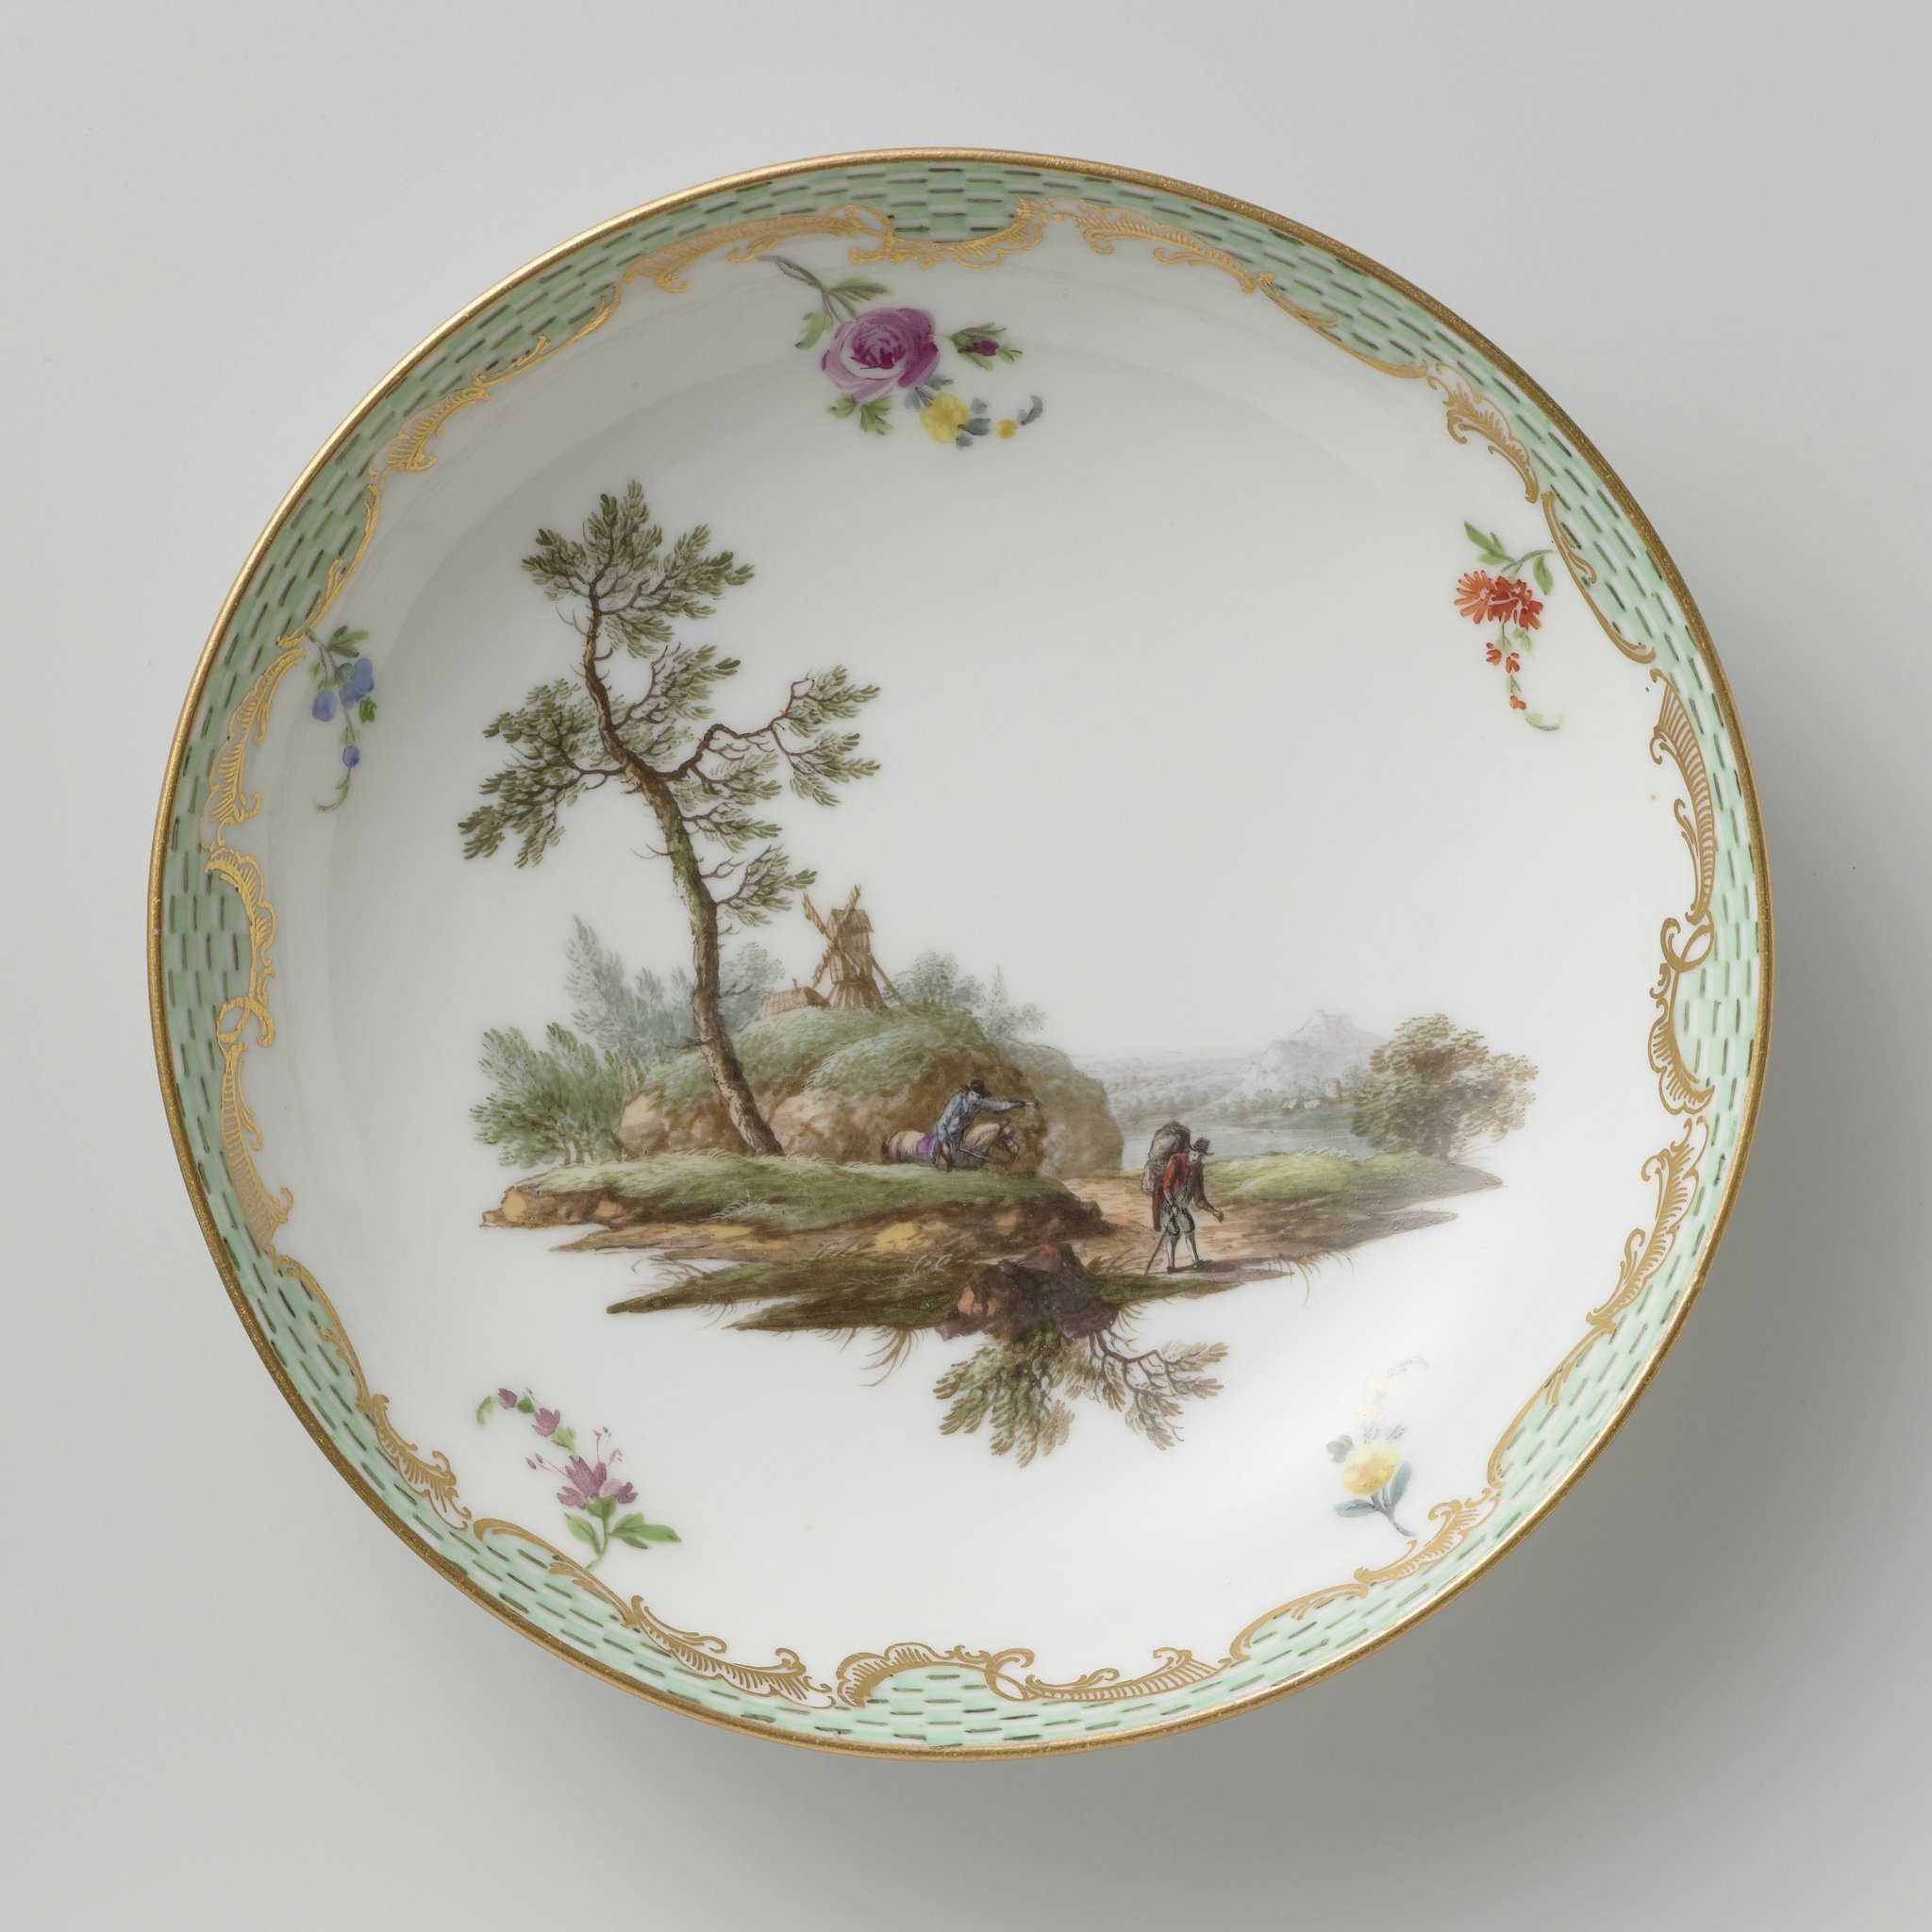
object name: platter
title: Schotel, veelkleurig beschilderd met een landschap met figuren.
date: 1777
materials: porcelain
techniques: painted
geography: meissen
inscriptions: factory mark, mold mark: ‘MM’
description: Ronde schotel van beschilderd porselein. De schotel is beschilderd met landschappen waarin figuren en langs de rand een brede strook groen vlechtwerk. De schotel is gemerkt.